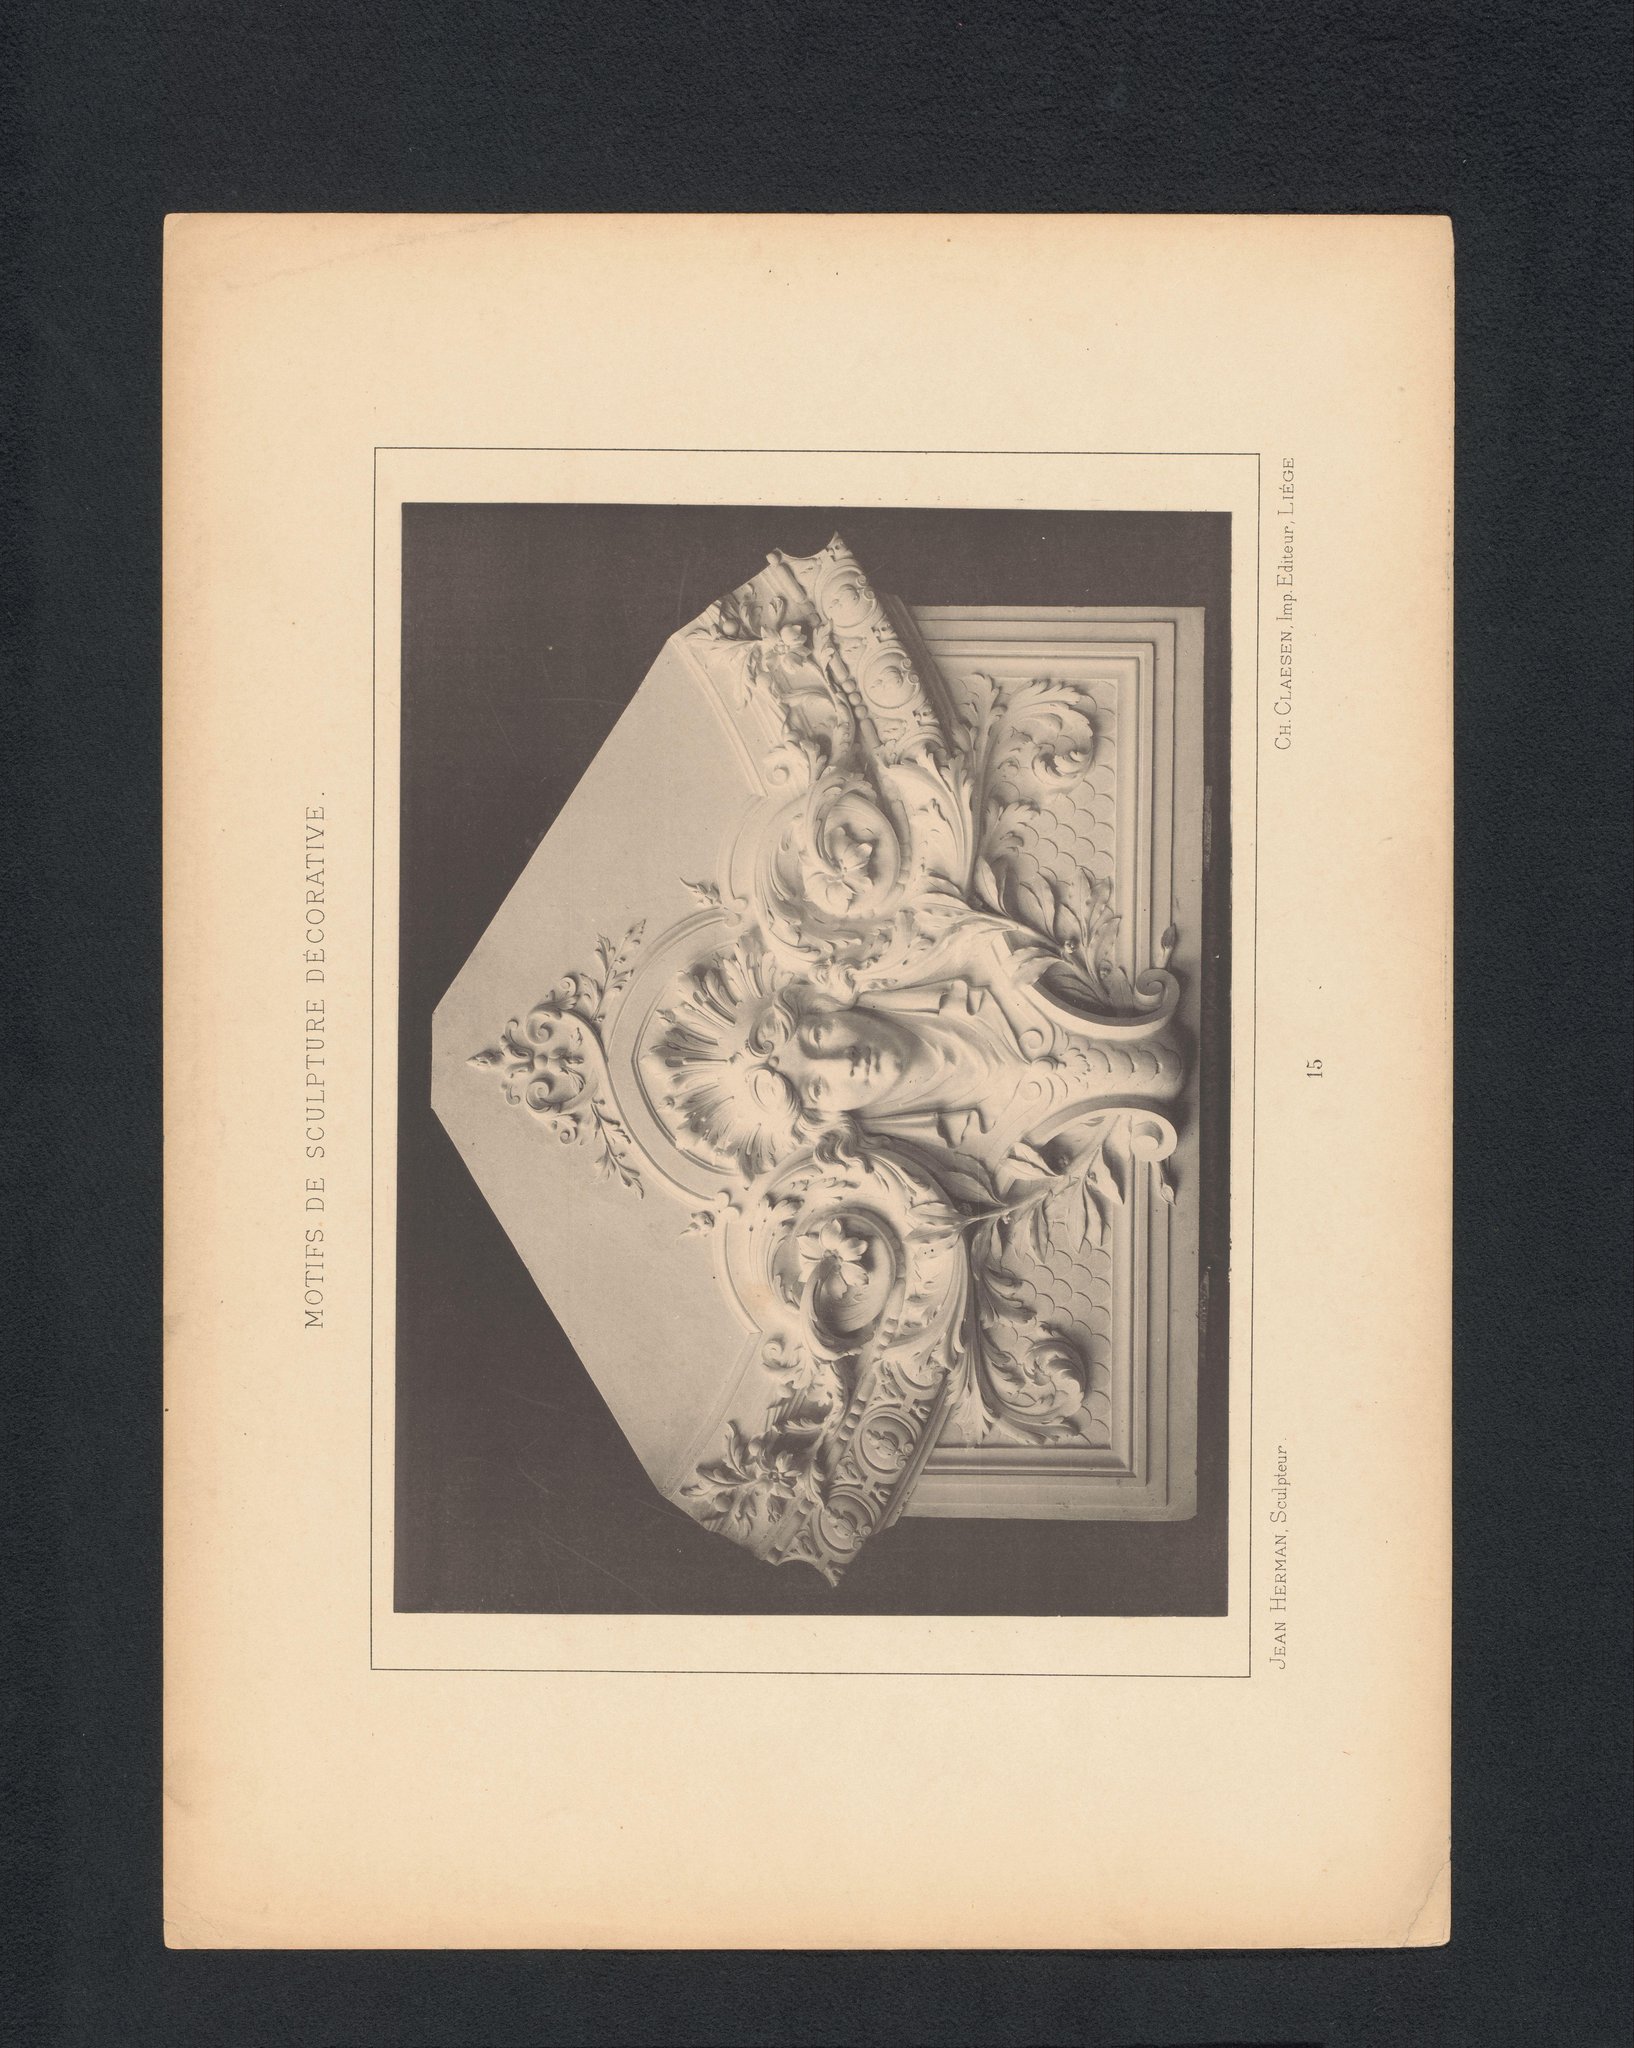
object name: photomechanical print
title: Reliëf met bladranken en een gezicht, gebeeldhouwd door Jean Herman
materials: paper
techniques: photograph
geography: liège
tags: face, foliage, tendrils, branches ~ ornament, sculpture (+ relief ~ sculpture)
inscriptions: inscription: ‘Jean Herman, Sculpteur.’, number: ‘15’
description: Deze prent maakt deel uit van een omslag met 28 prenten en een titelblad.